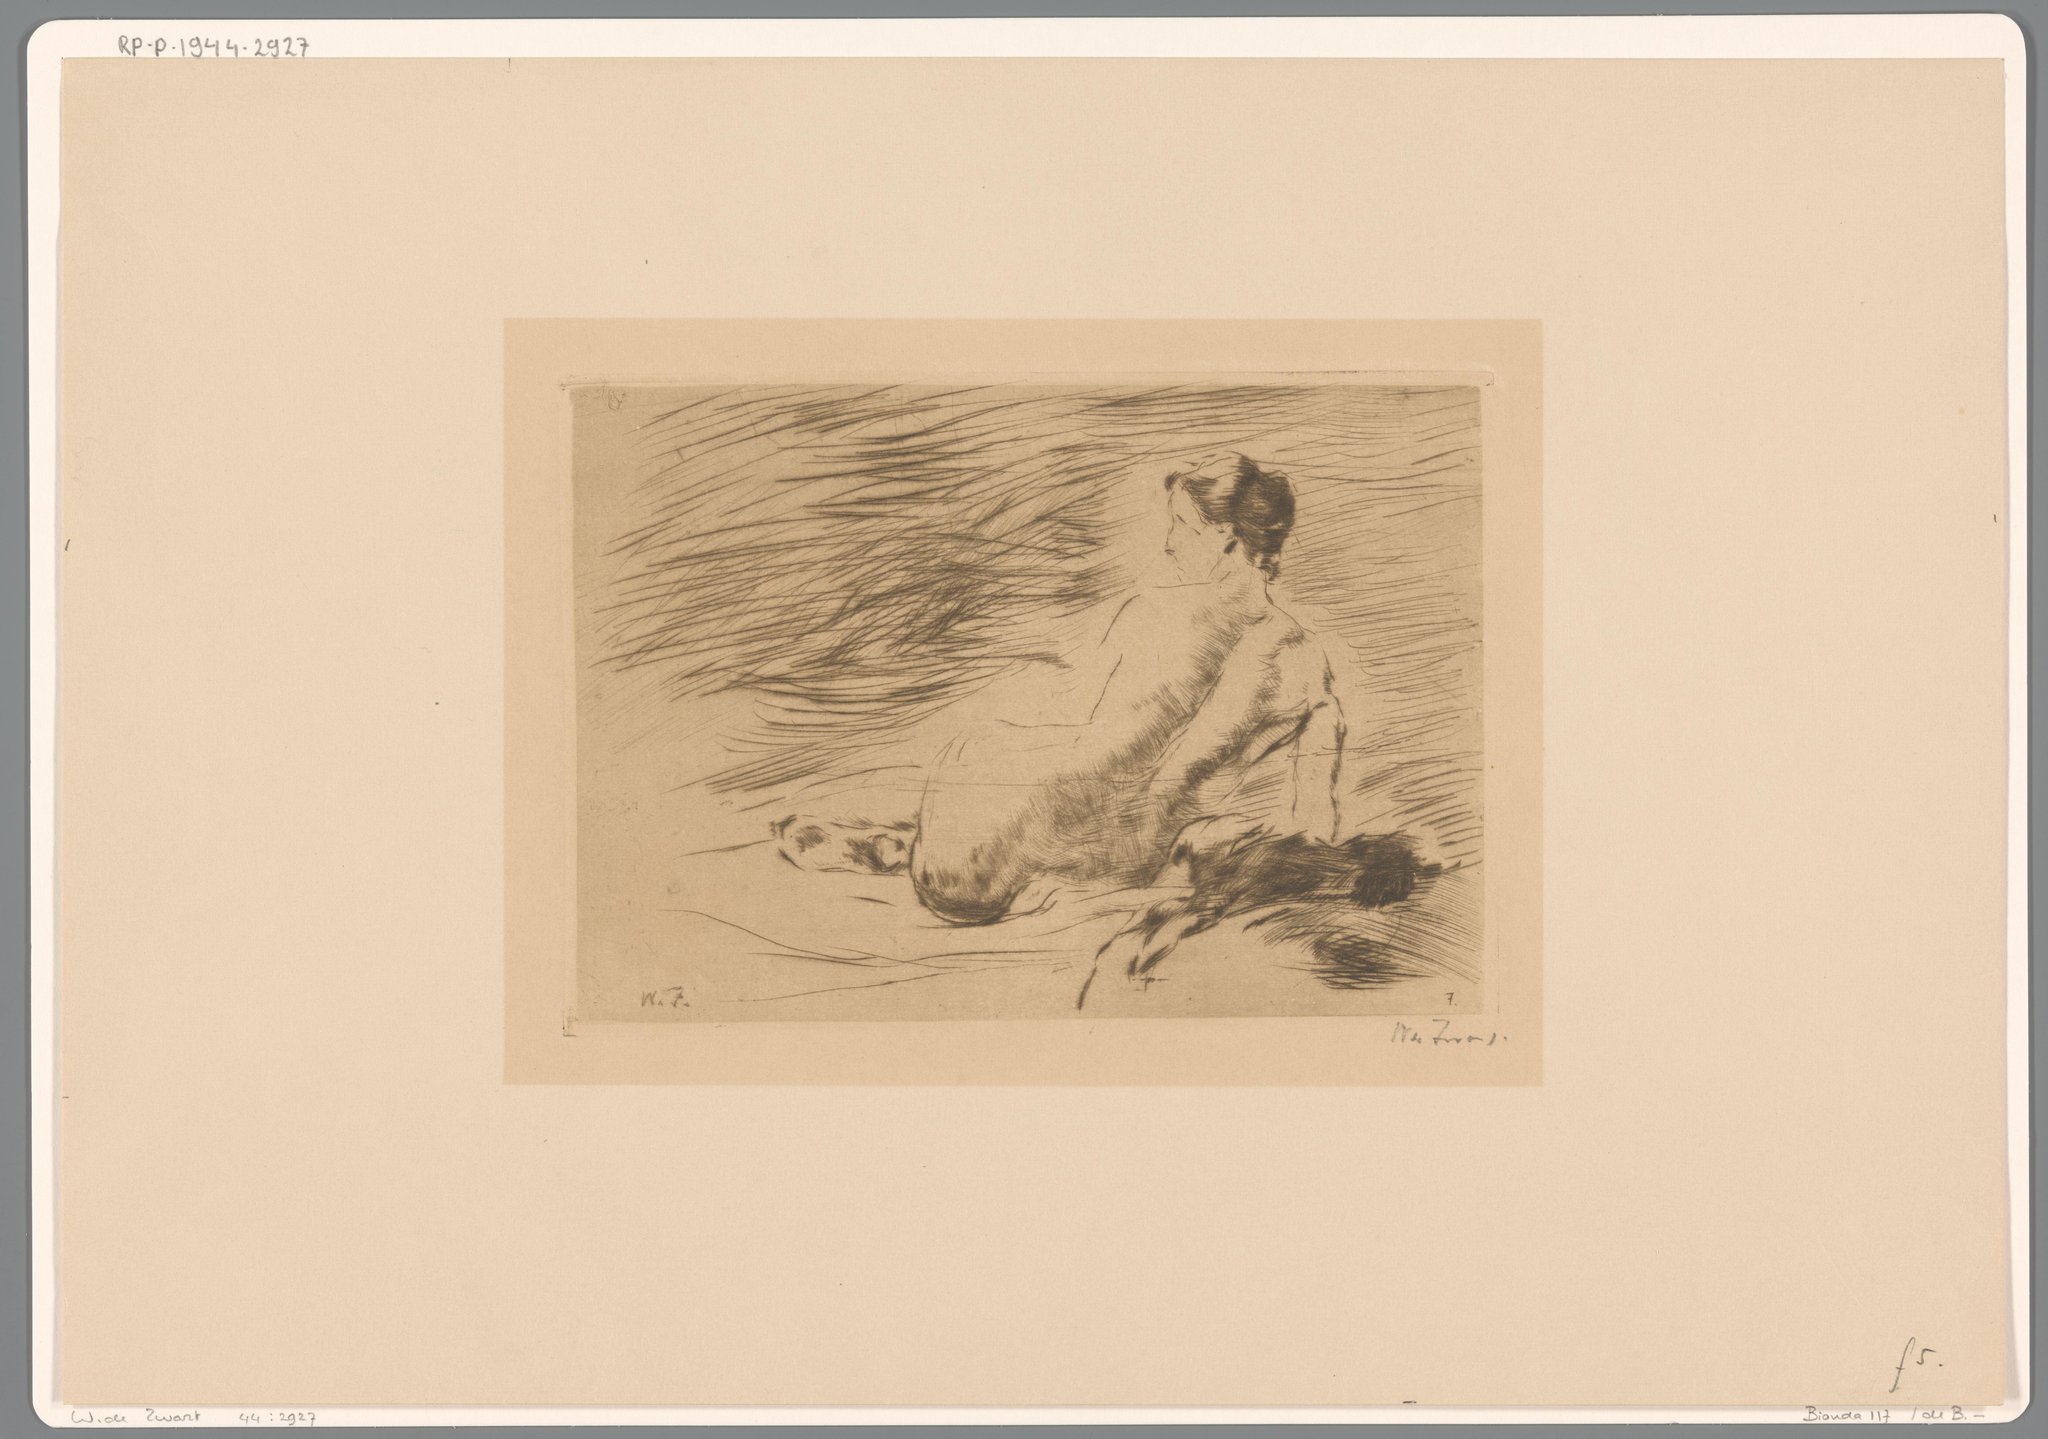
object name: print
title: Liggende naakte vrouw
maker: willem de zwart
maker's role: draughtsman, painter, print maker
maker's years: 1862-1931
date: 1924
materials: paper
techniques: drypoint, intaglio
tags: lying figure - aa - female human figure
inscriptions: collector's mark: Lugt 2228, collector's mark: Lugt 2760